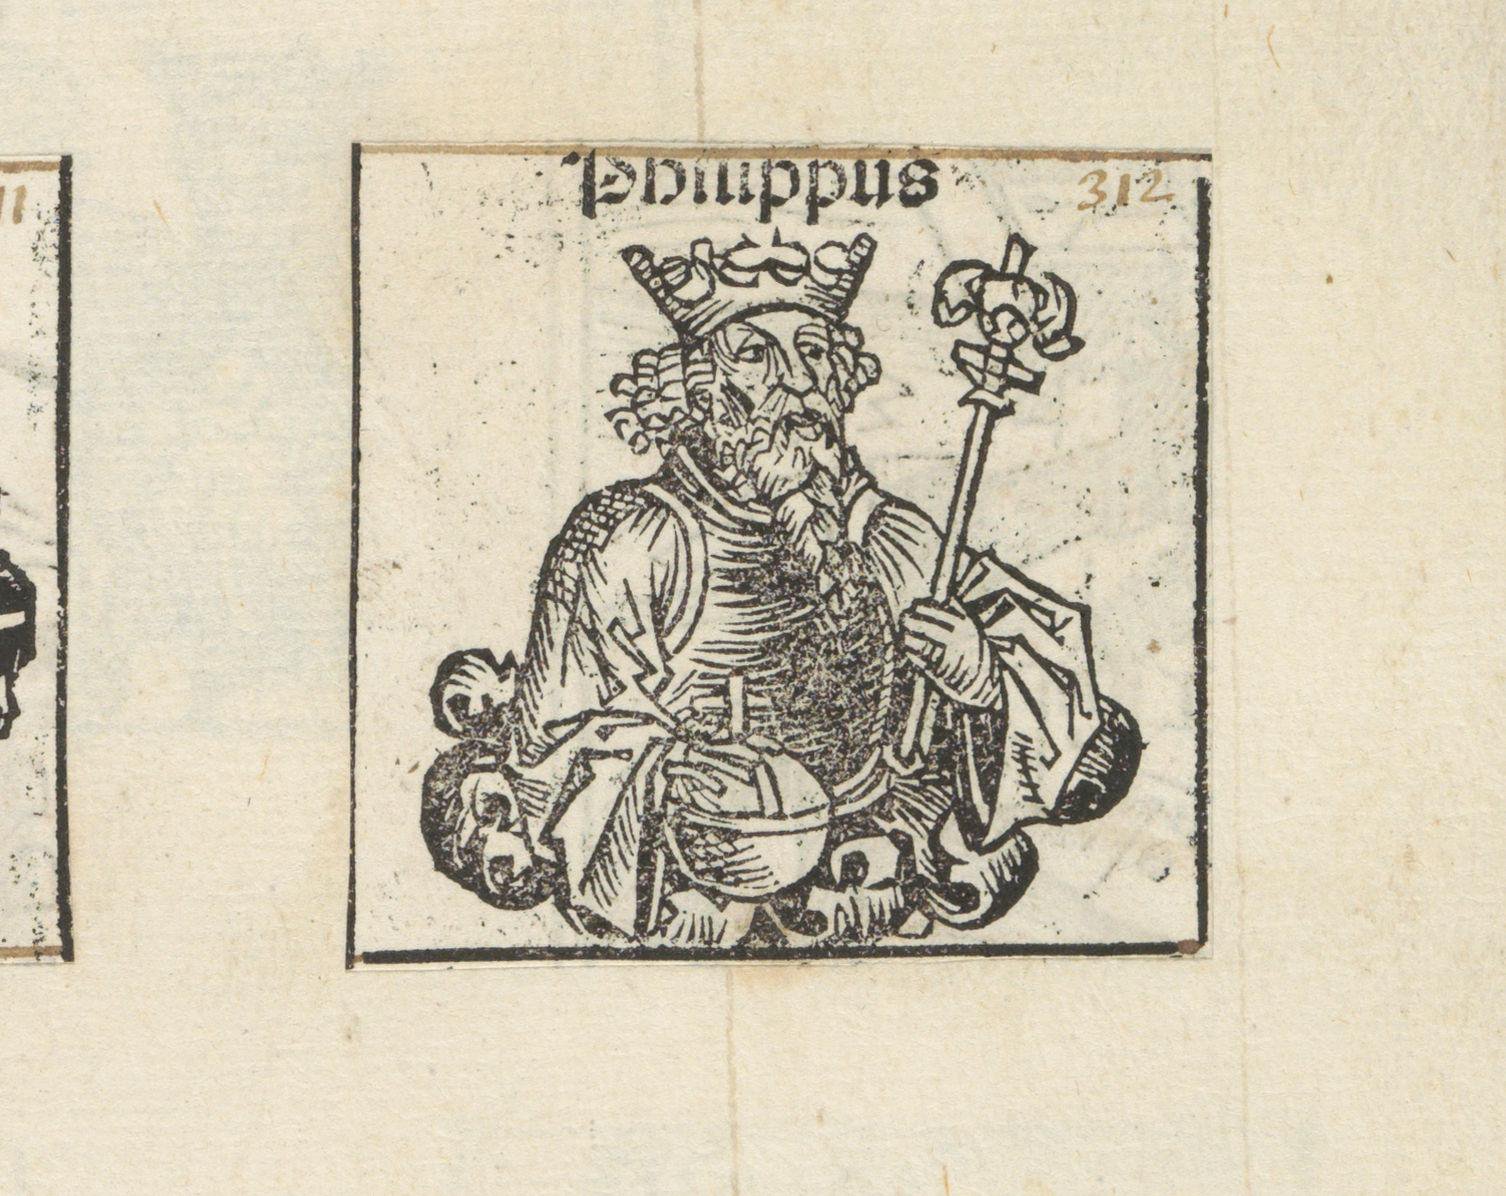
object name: album leaf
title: Liber Chronicarum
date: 1493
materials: paper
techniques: letterpress printing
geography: nuremberg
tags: king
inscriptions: inscription: ‘312’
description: Een bloemkelk met een koning, naar rechts gekeerd. De man heeft een rijksappel en een scepter in zijn handen. De voorstelling is onderdeel van de opeenvolging Syrische koningen in de Liber Chronicarum. De tekst identificeert hem als de laatste koning van Syrië, genaamd Philip. Mogelijk wordt hier Philip II Philoromaeus bedoeld. De prent maakt deel uit van een album.